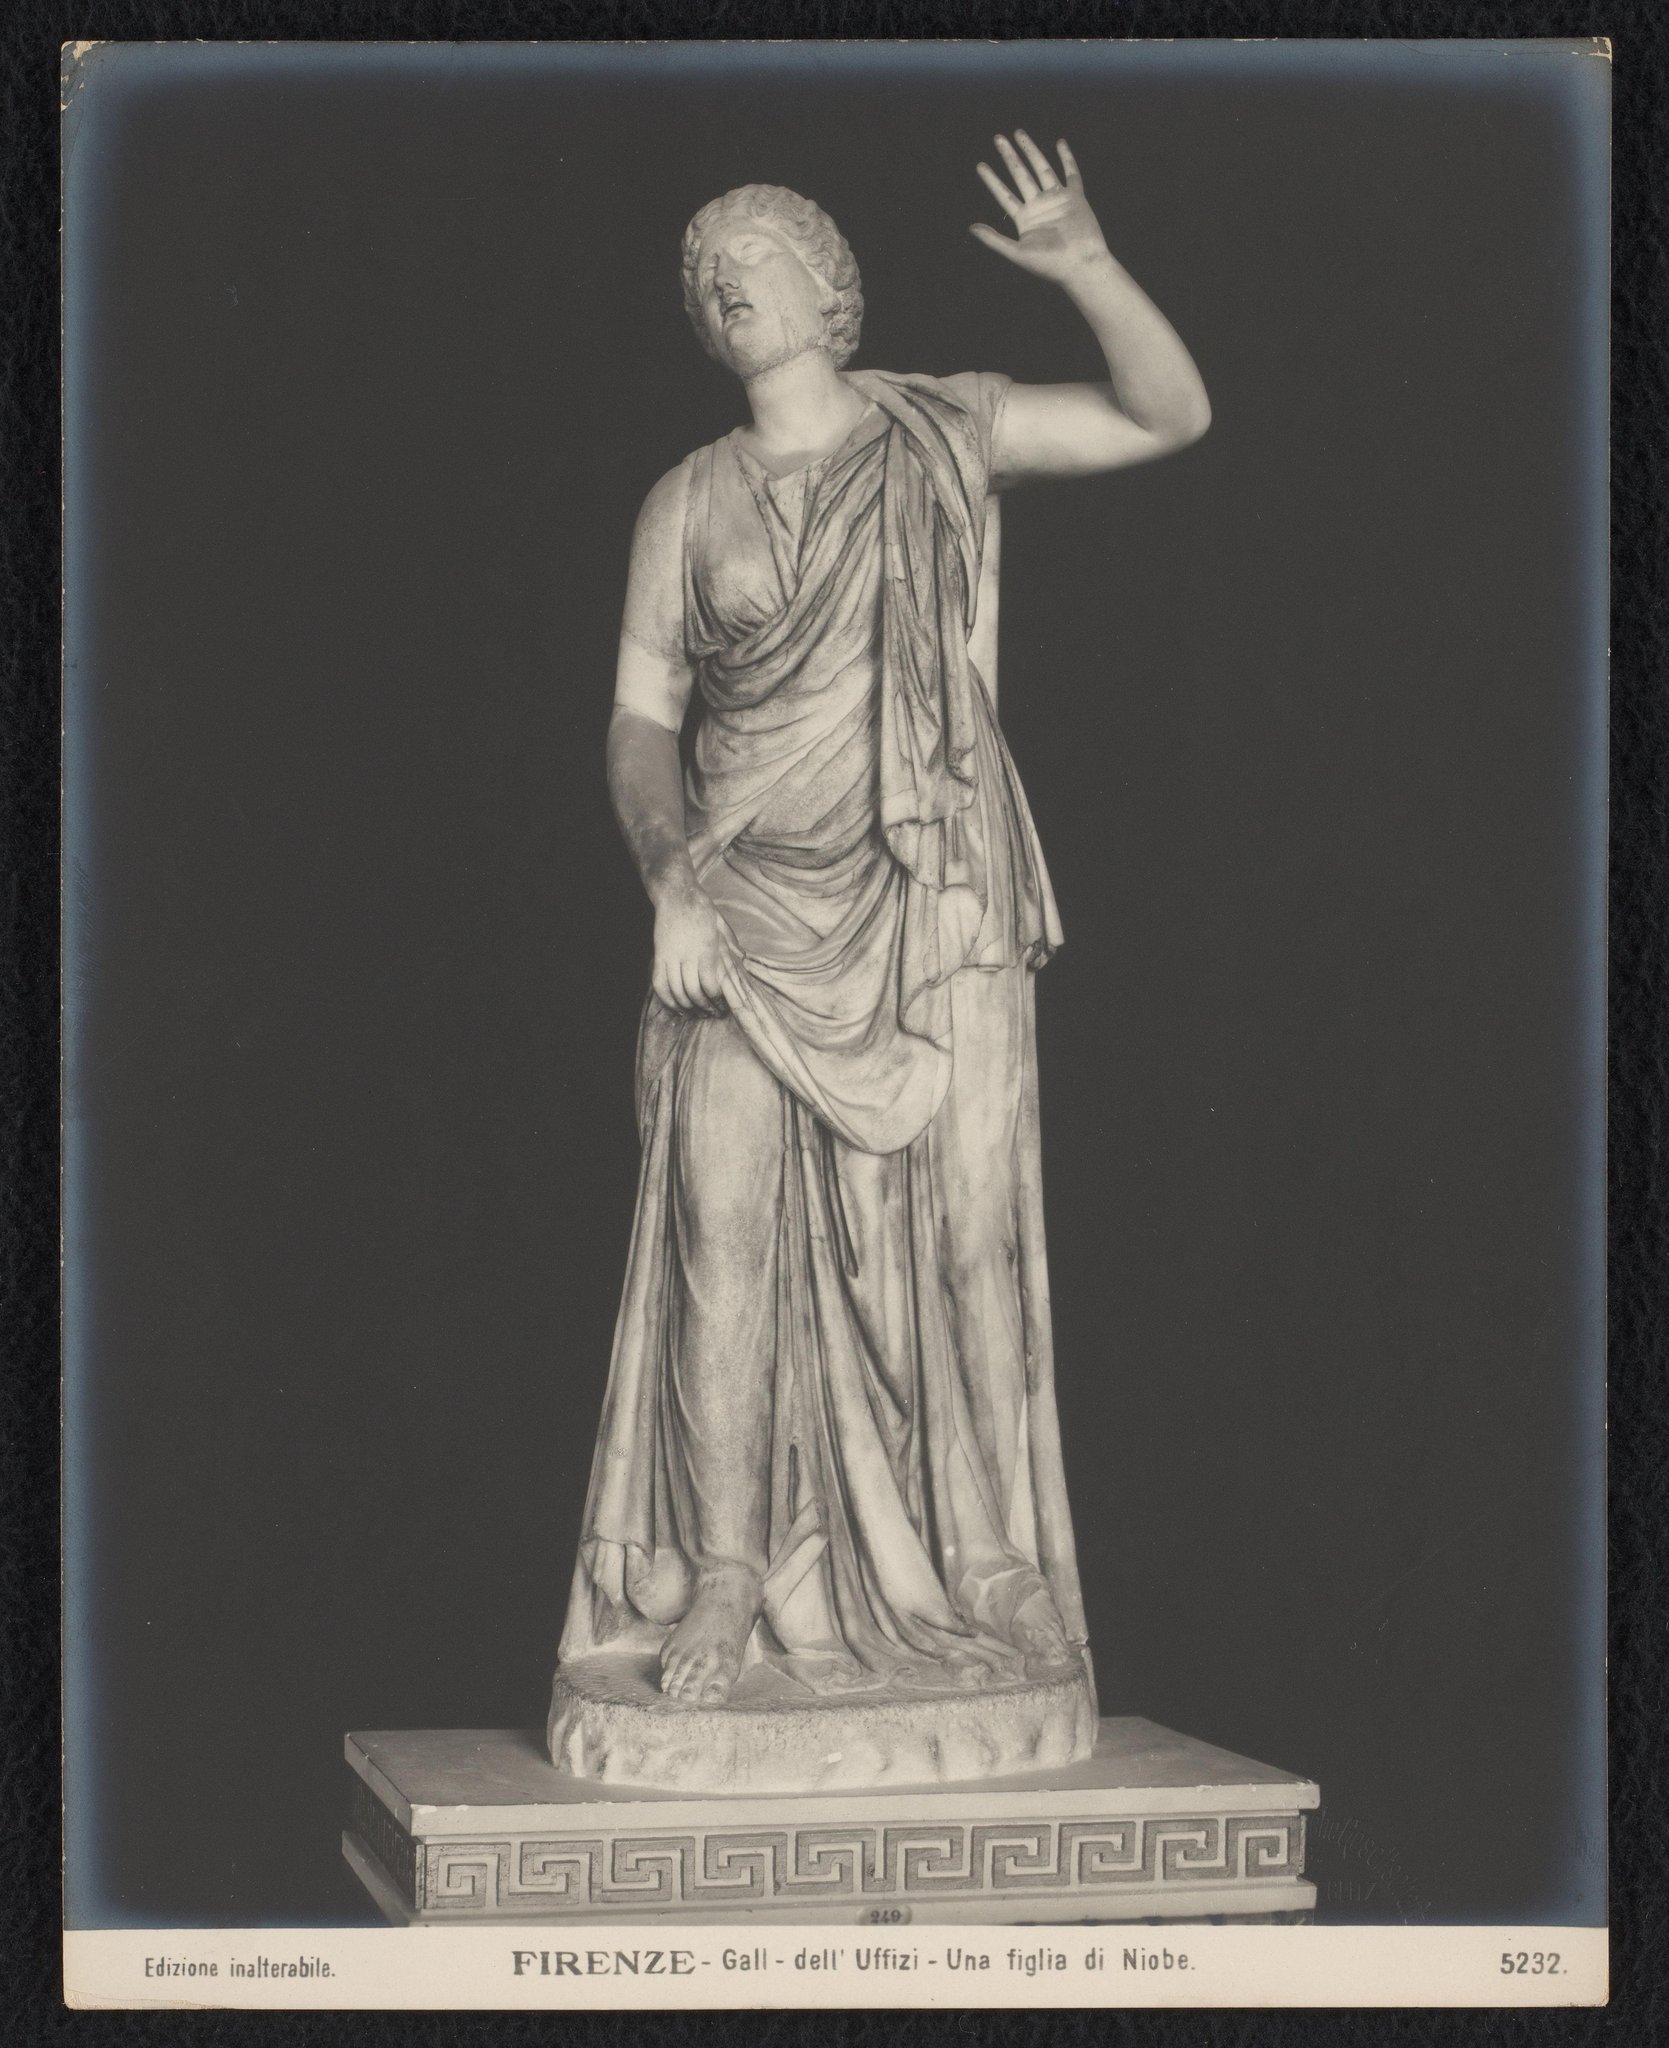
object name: photograph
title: Sculptuur van Niobe in de Galleria degli Uffizi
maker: Anonymous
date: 1901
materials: paper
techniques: gelatin silver print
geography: florence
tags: (story of) bacchus (dionysus), liber, piece of sculpture, reproduction of a piece of sculpture, (story of) niobe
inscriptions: number: ‘5232.’, collector's mark: ‘RIJKS SCHOOL VOOR KUNSTNIJVERHEID/ GROEP’, inscription: ‘Edizione inalterabile.’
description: Deze foto maakt deel uit van een omslag.